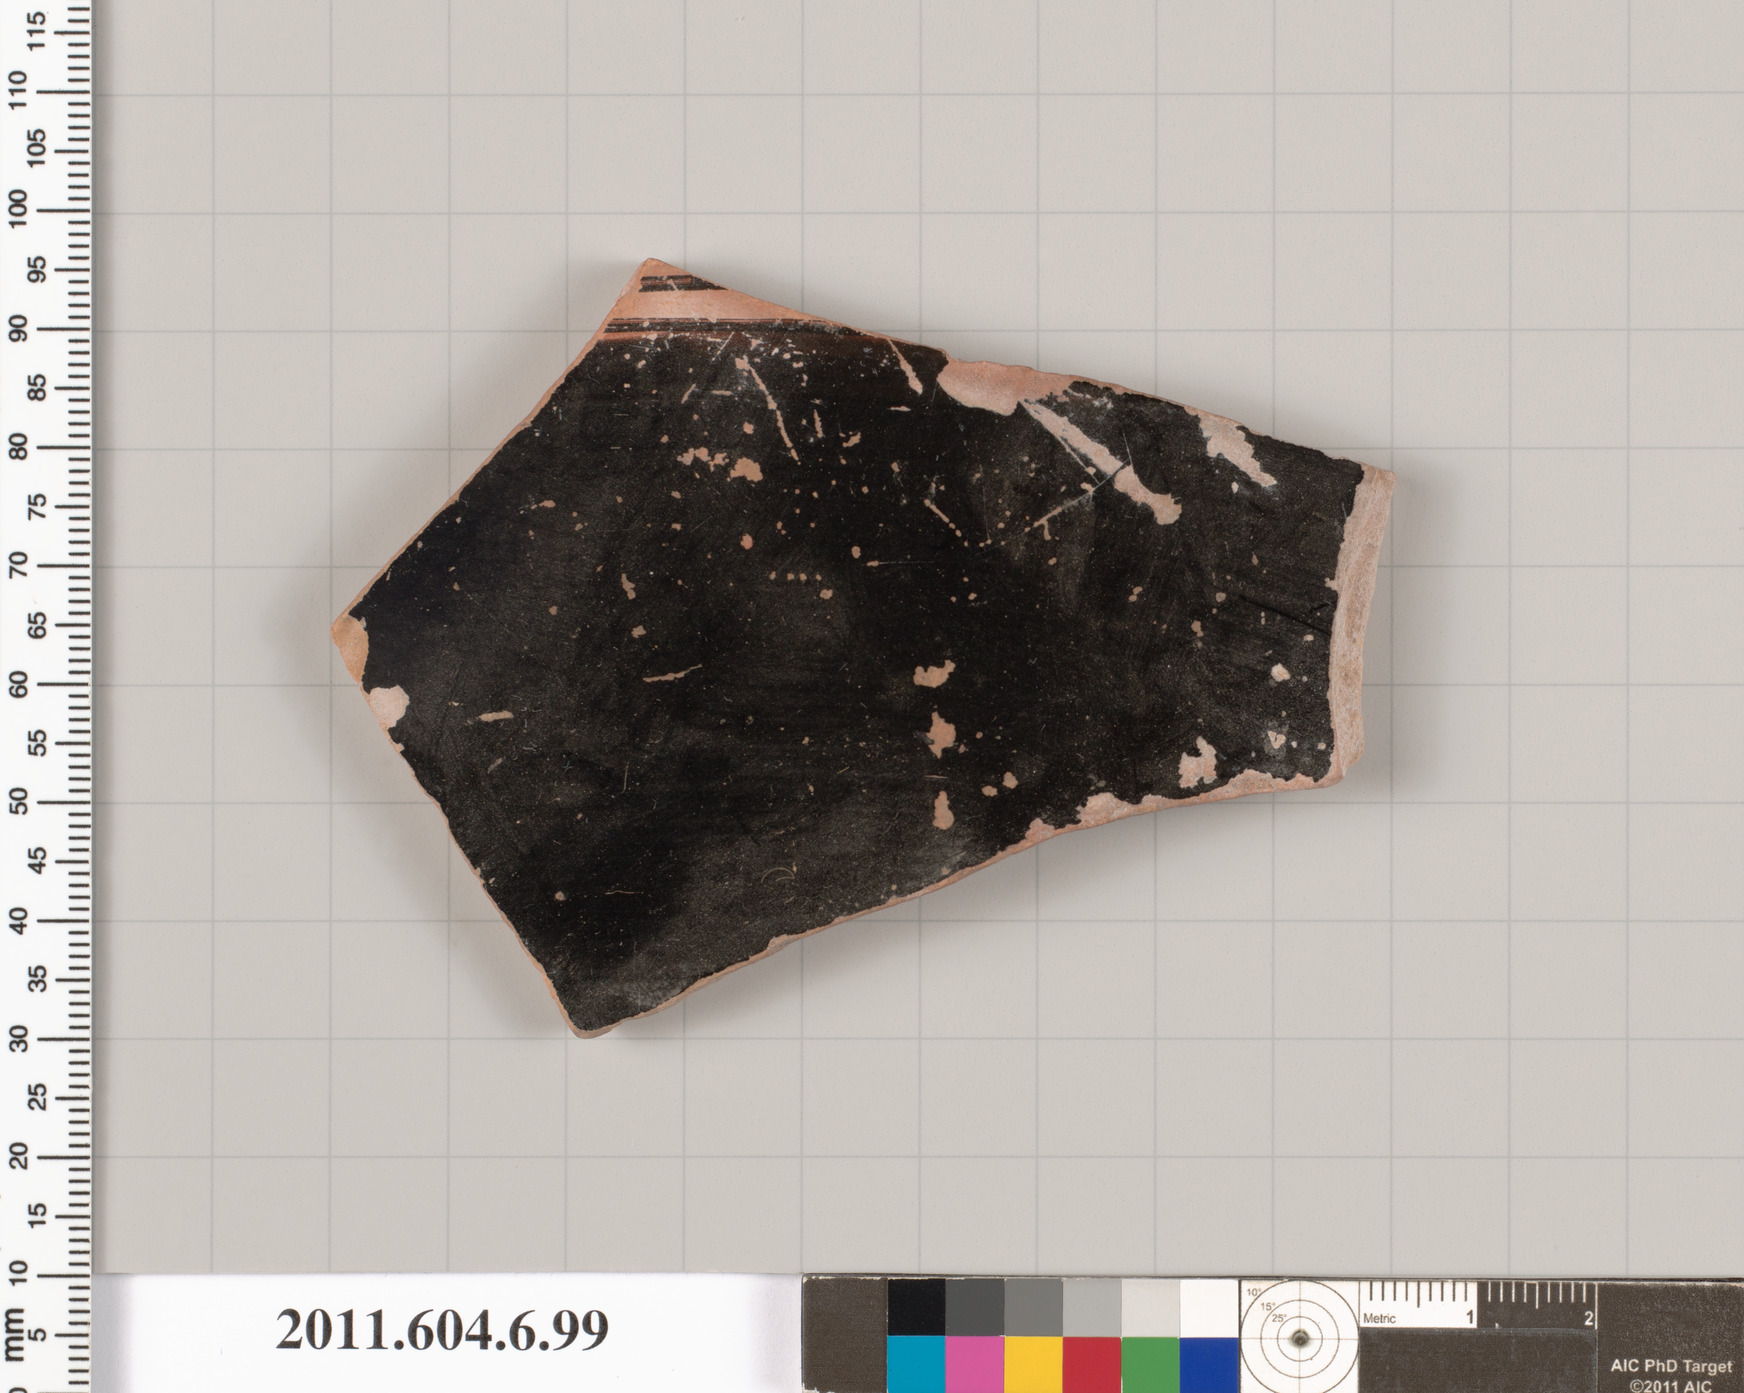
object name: undetermined closed shape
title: Terracotta fragment of a closed shape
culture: greek, attic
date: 600-401 BCE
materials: terracotta